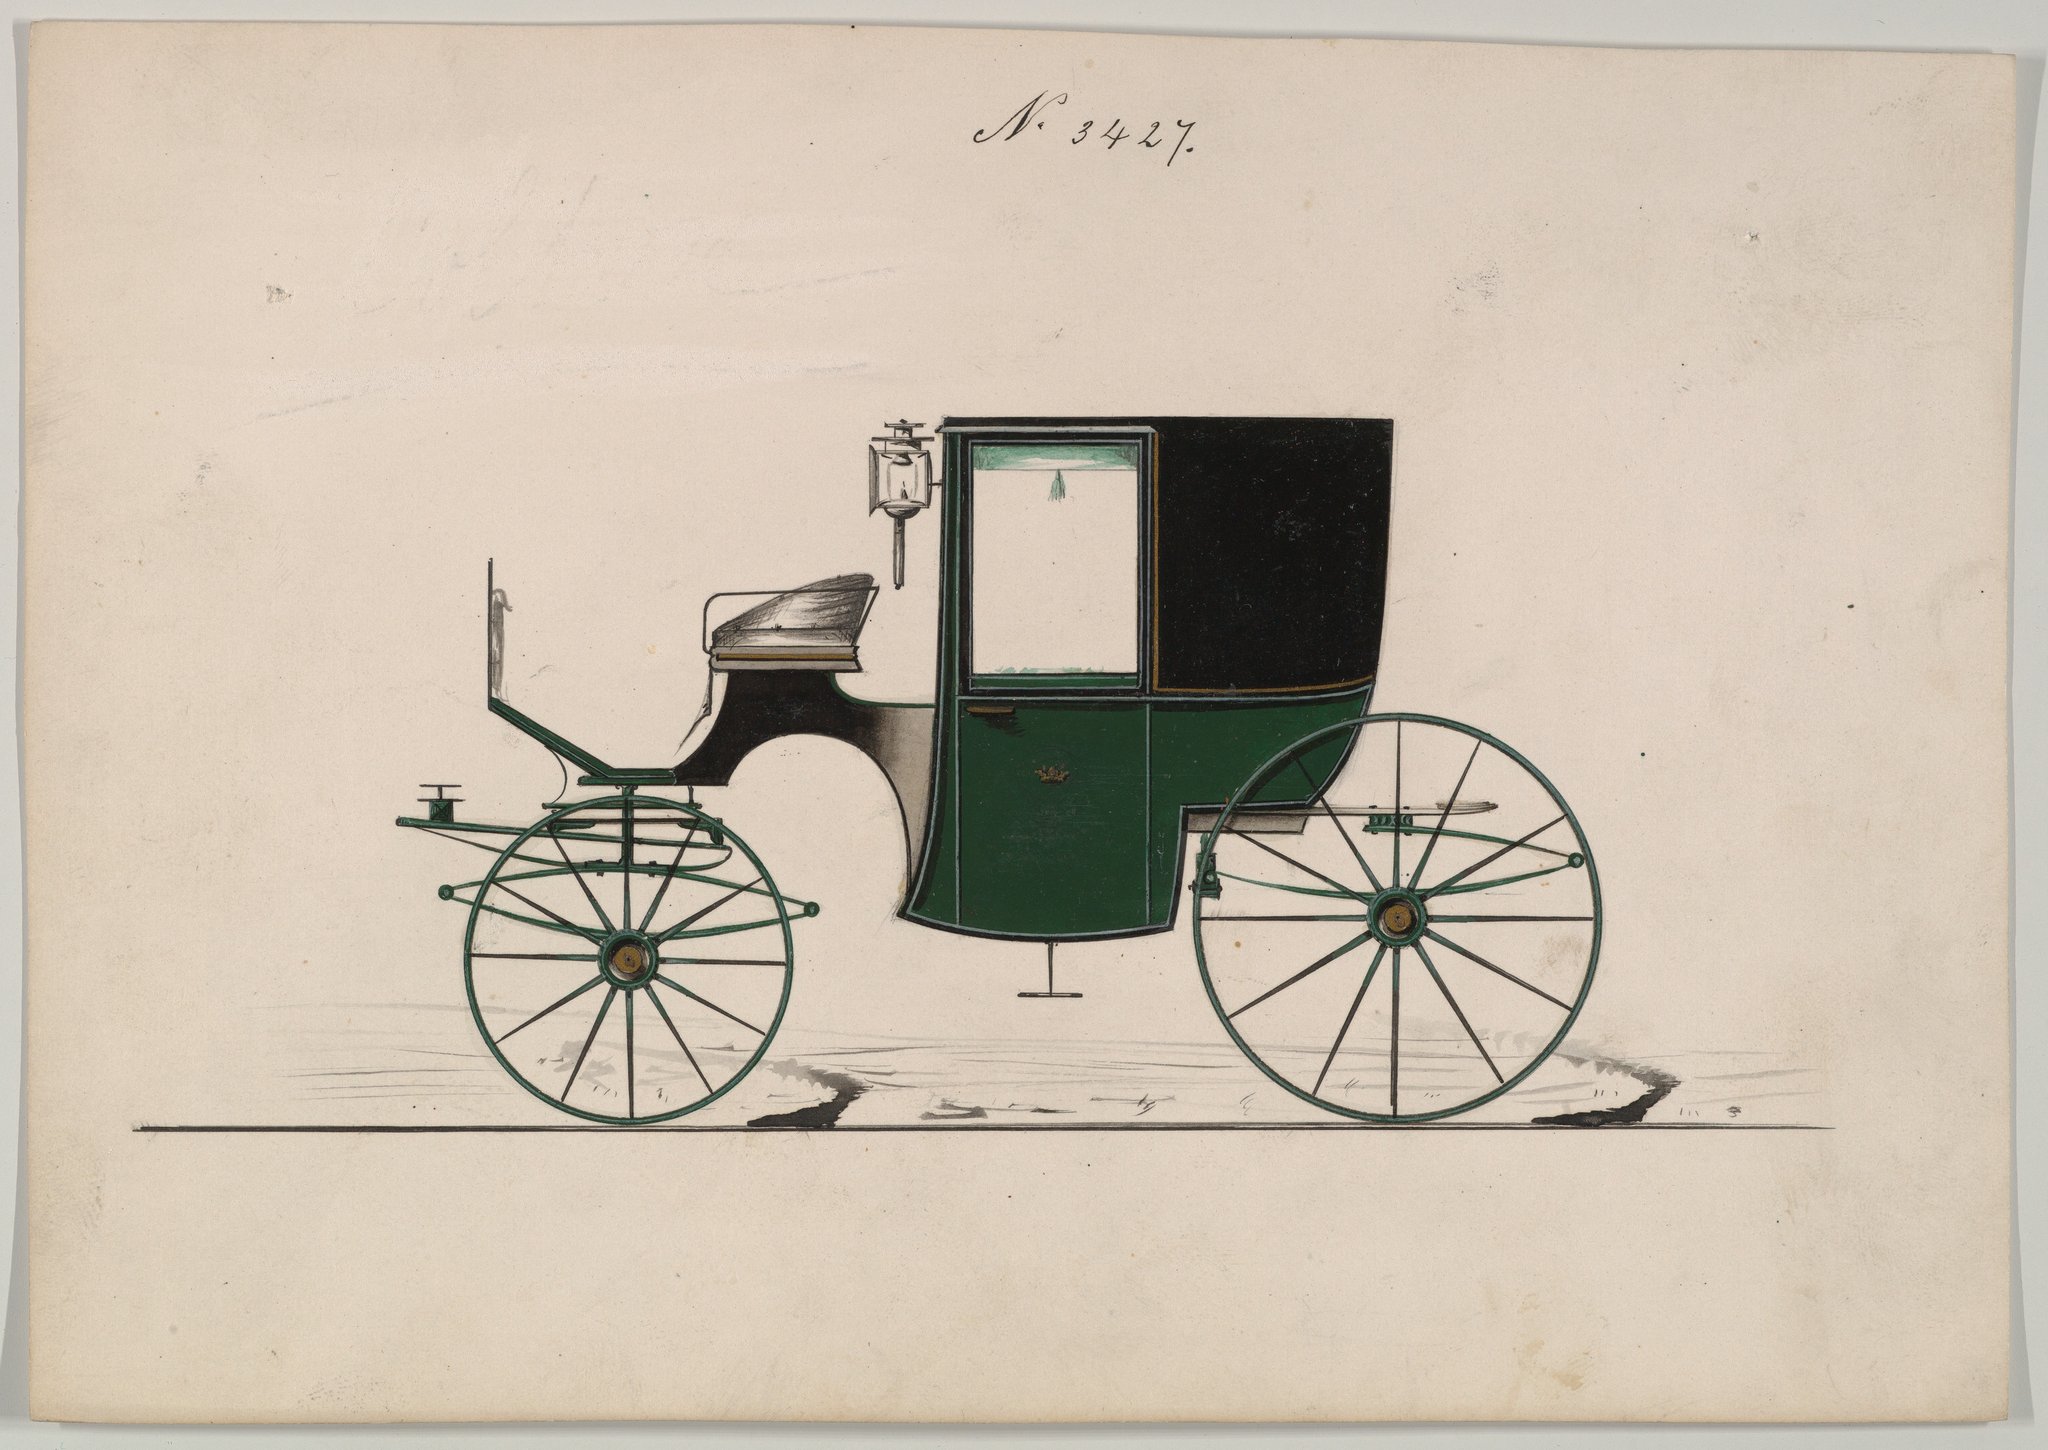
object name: drawing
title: Brougham #3427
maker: brewster & co.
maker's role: manufacturer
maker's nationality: american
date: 1878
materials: gouache, gum arabic, ink, watercolor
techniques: pen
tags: carriages